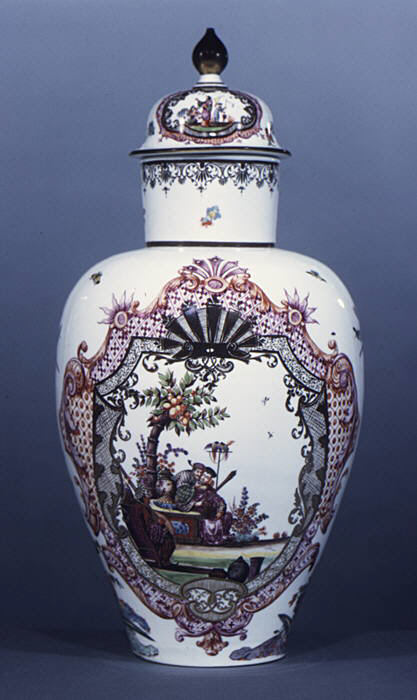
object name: vase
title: Vase (part of a set)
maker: meissen manufactory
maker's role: manufactory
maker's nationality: german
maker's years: 1710-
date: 1740-1750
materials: hard paste porcelain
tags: men,trees